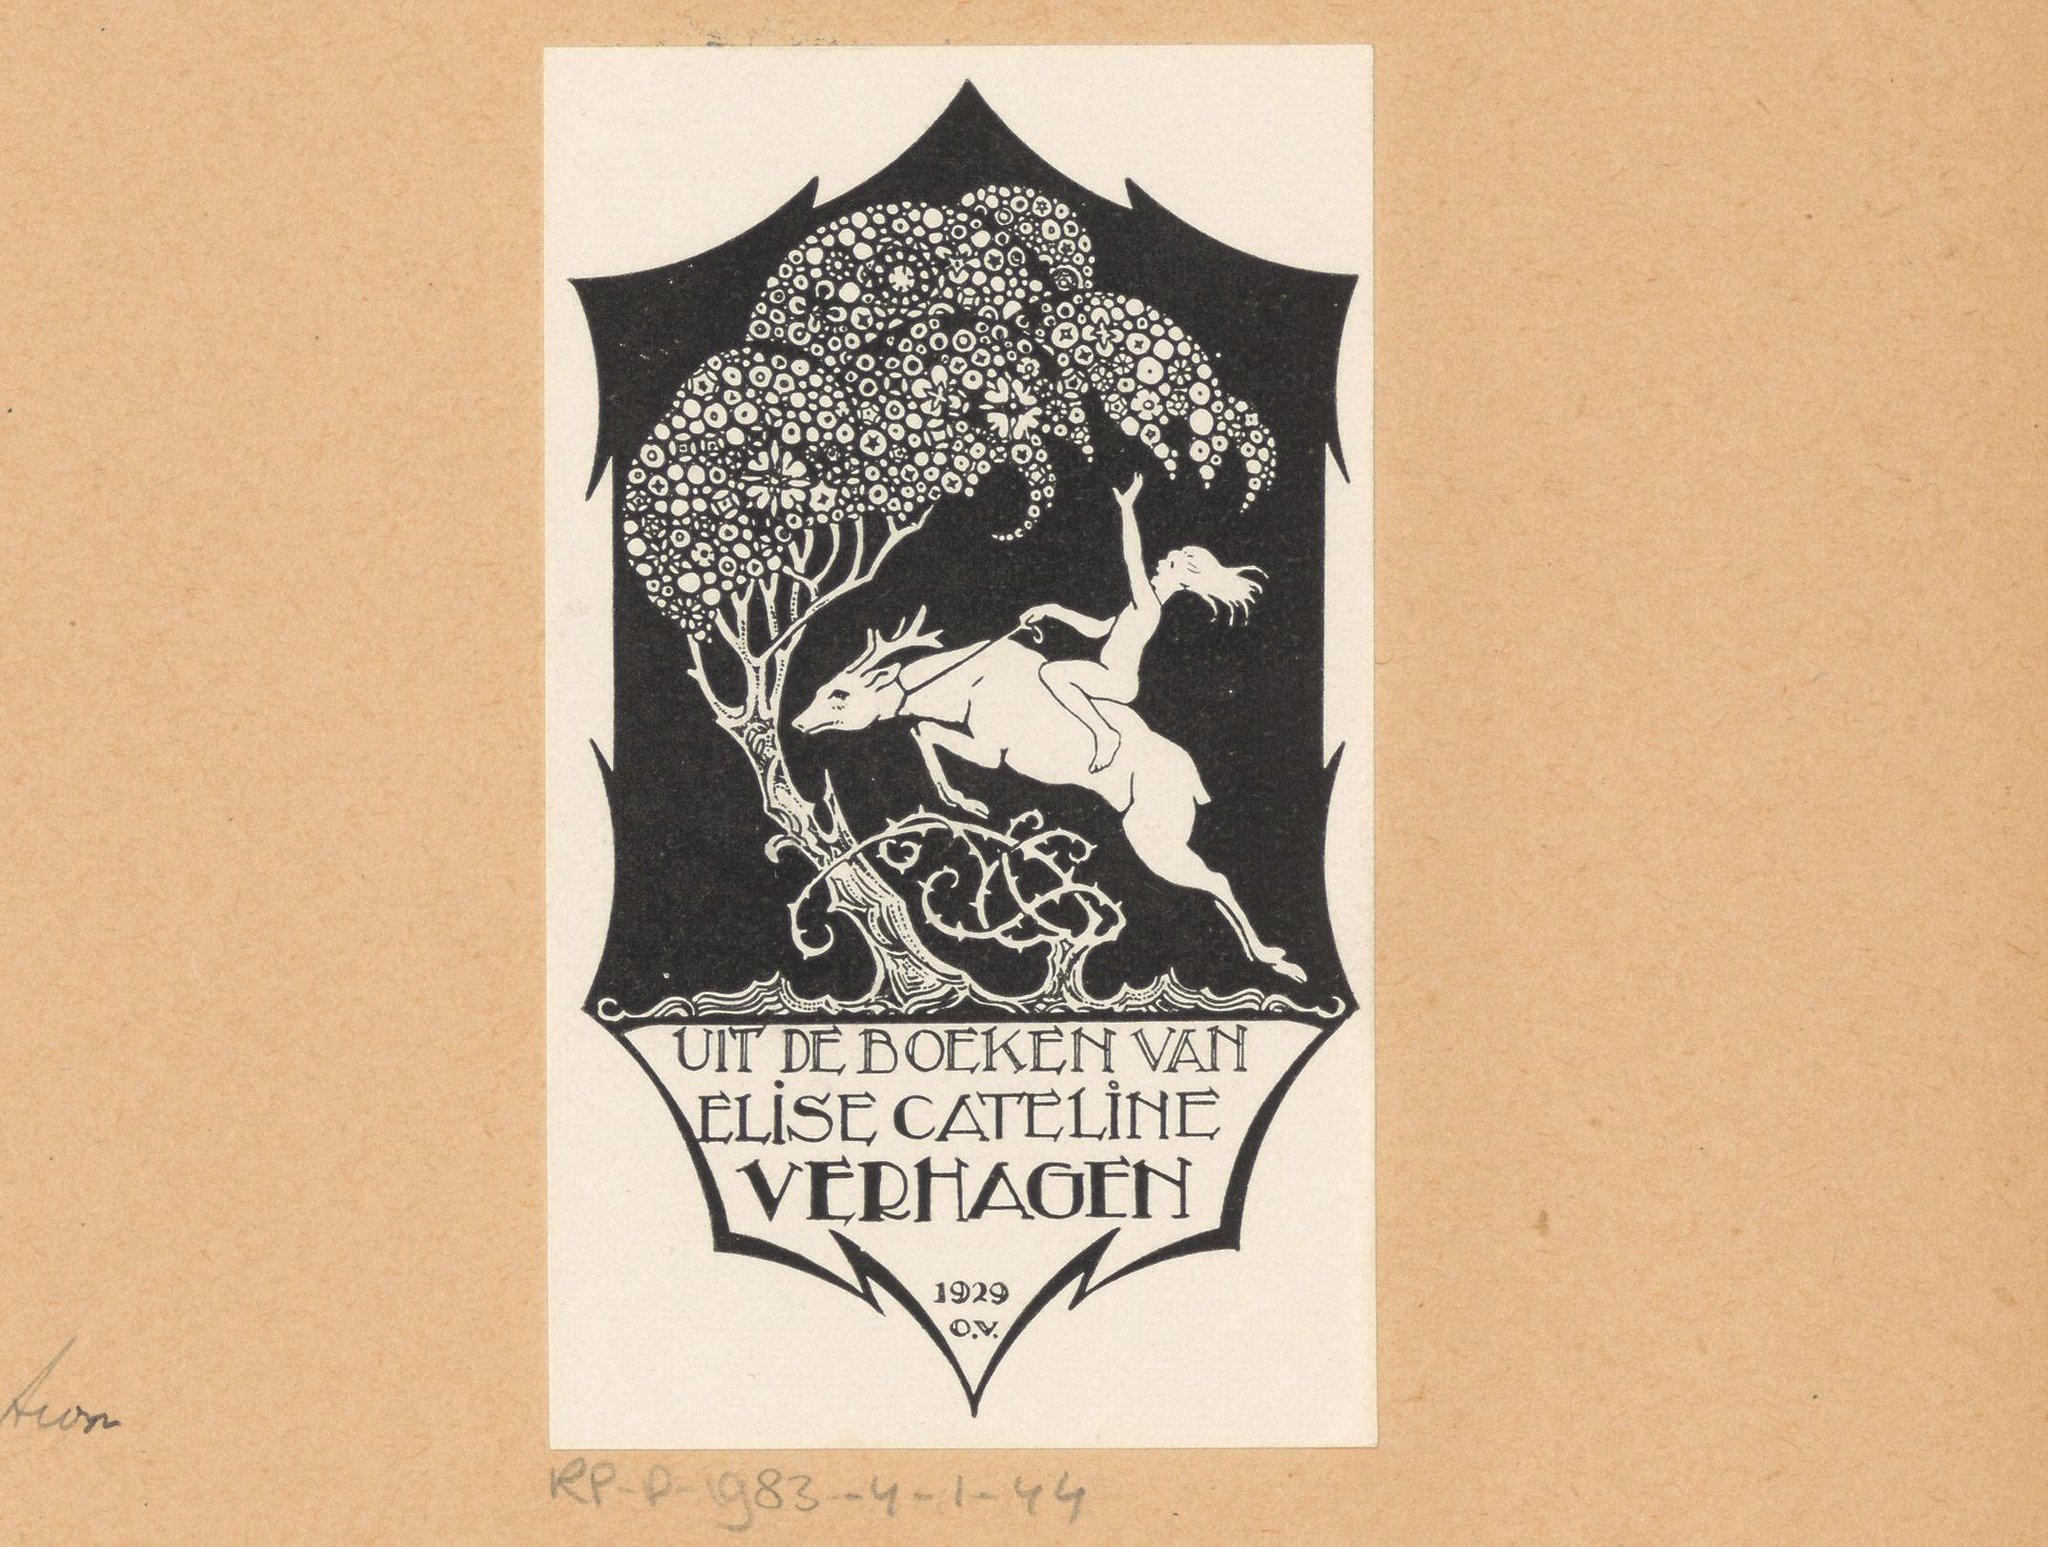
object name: bookplate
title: Uit de boeken van Elise Cateline Verhagen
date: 1929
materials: paper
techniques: printing block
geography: netherlands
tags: riding a horse, ass, or mule; rider, horseman, trees, hoofed animals: deer, girl (child between toddler and youth)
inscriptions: date